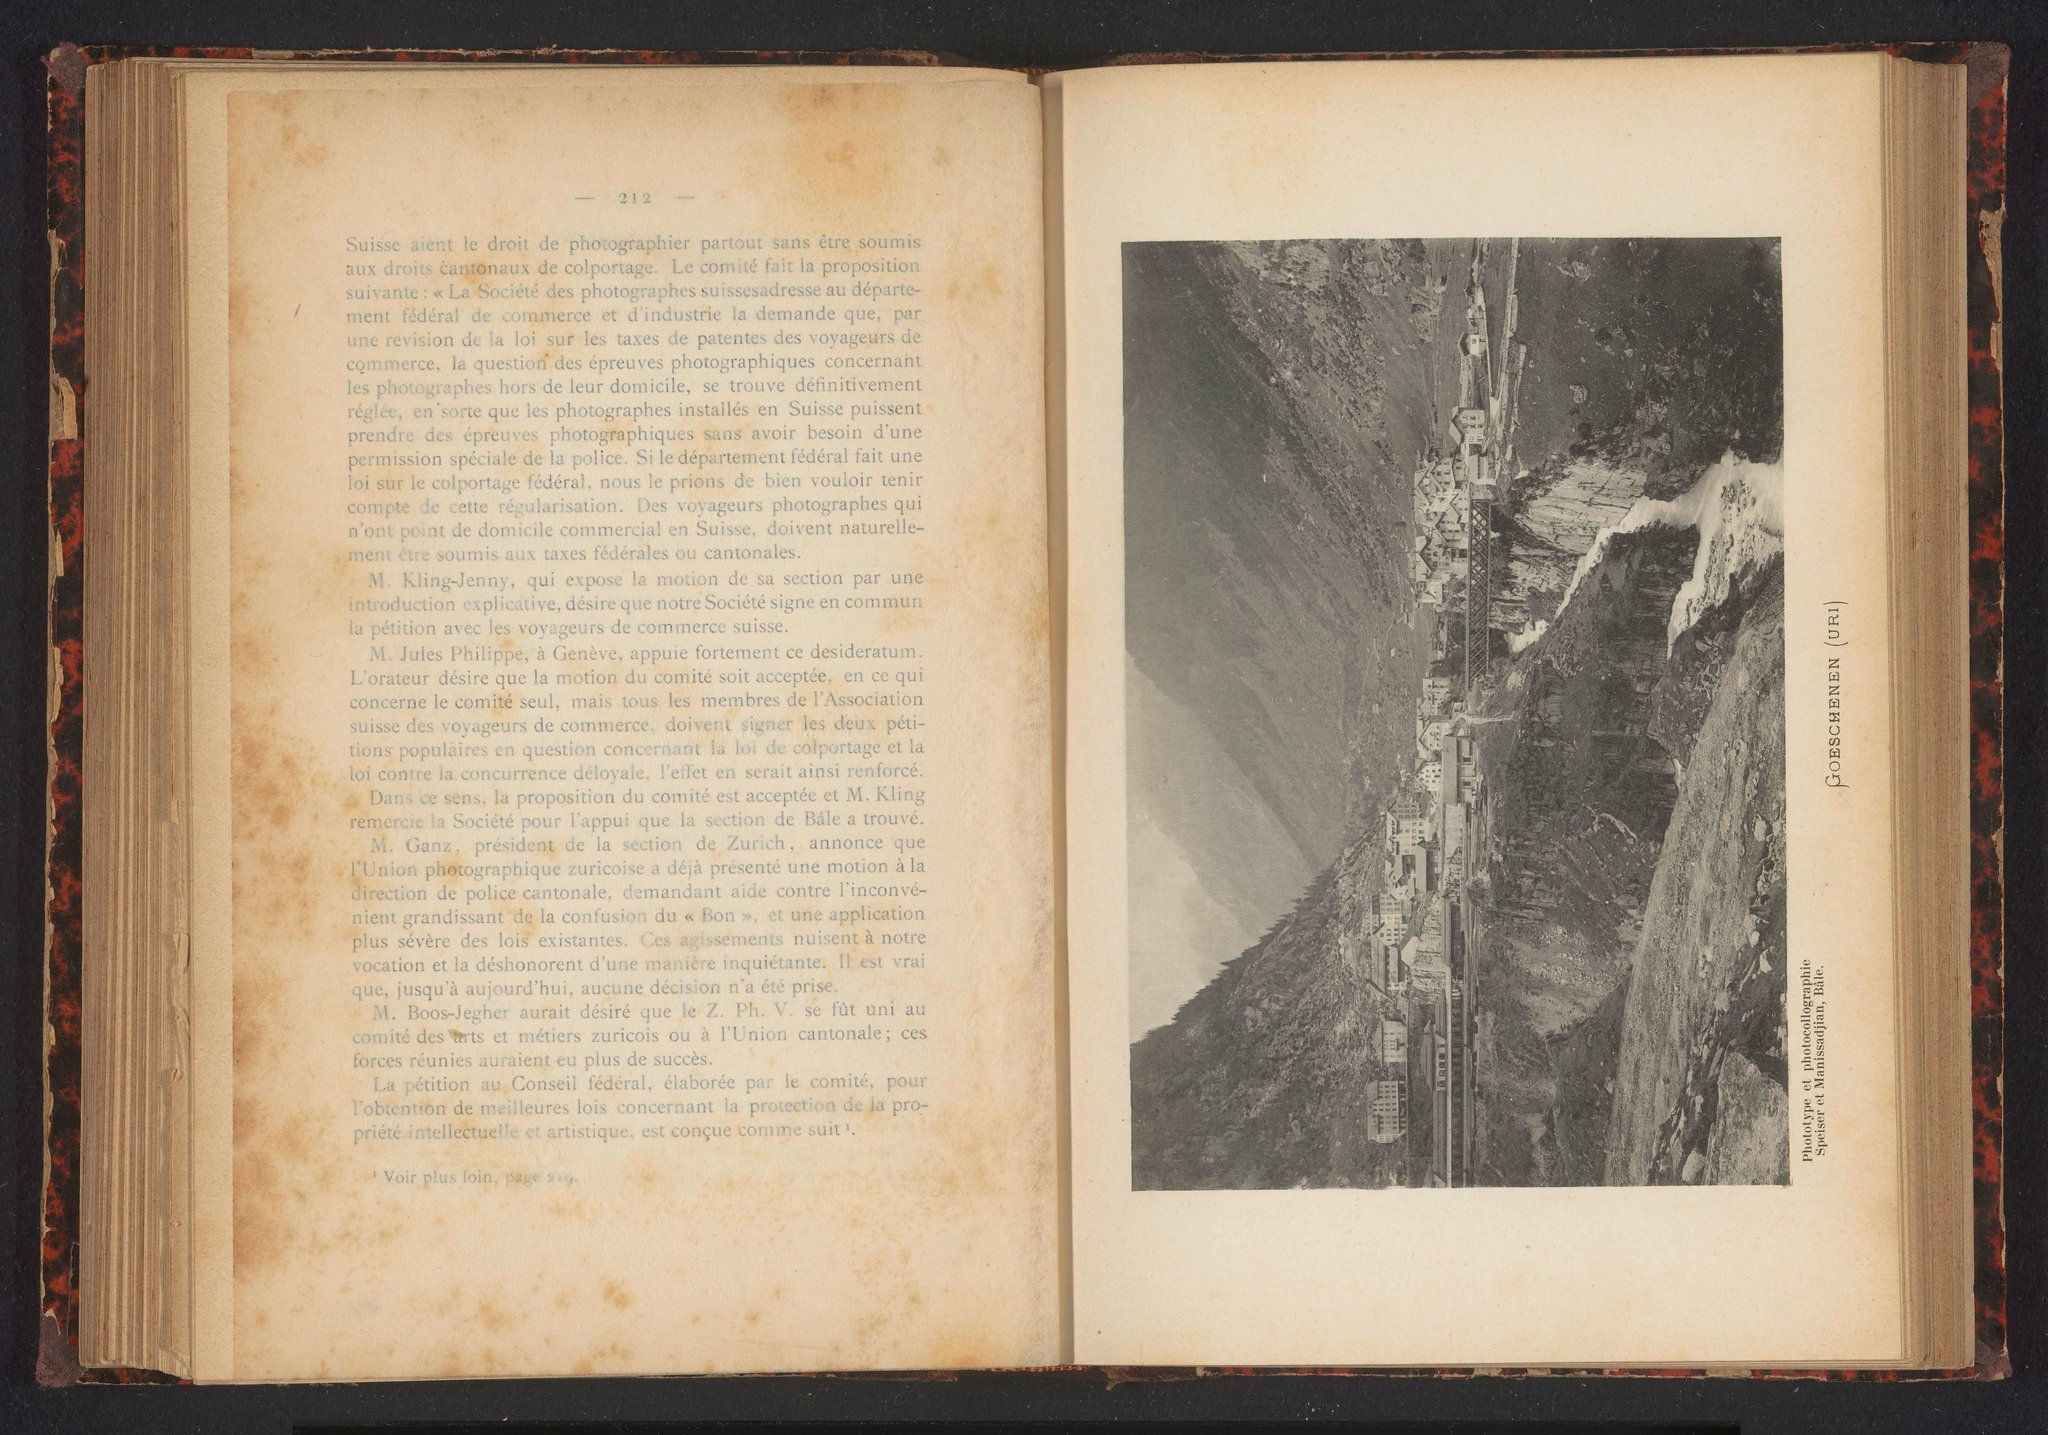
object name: page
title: Goeschenen (Uri)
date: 1895-1900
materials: paper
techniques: autotype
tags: city-view in general; 'veduta', mountains